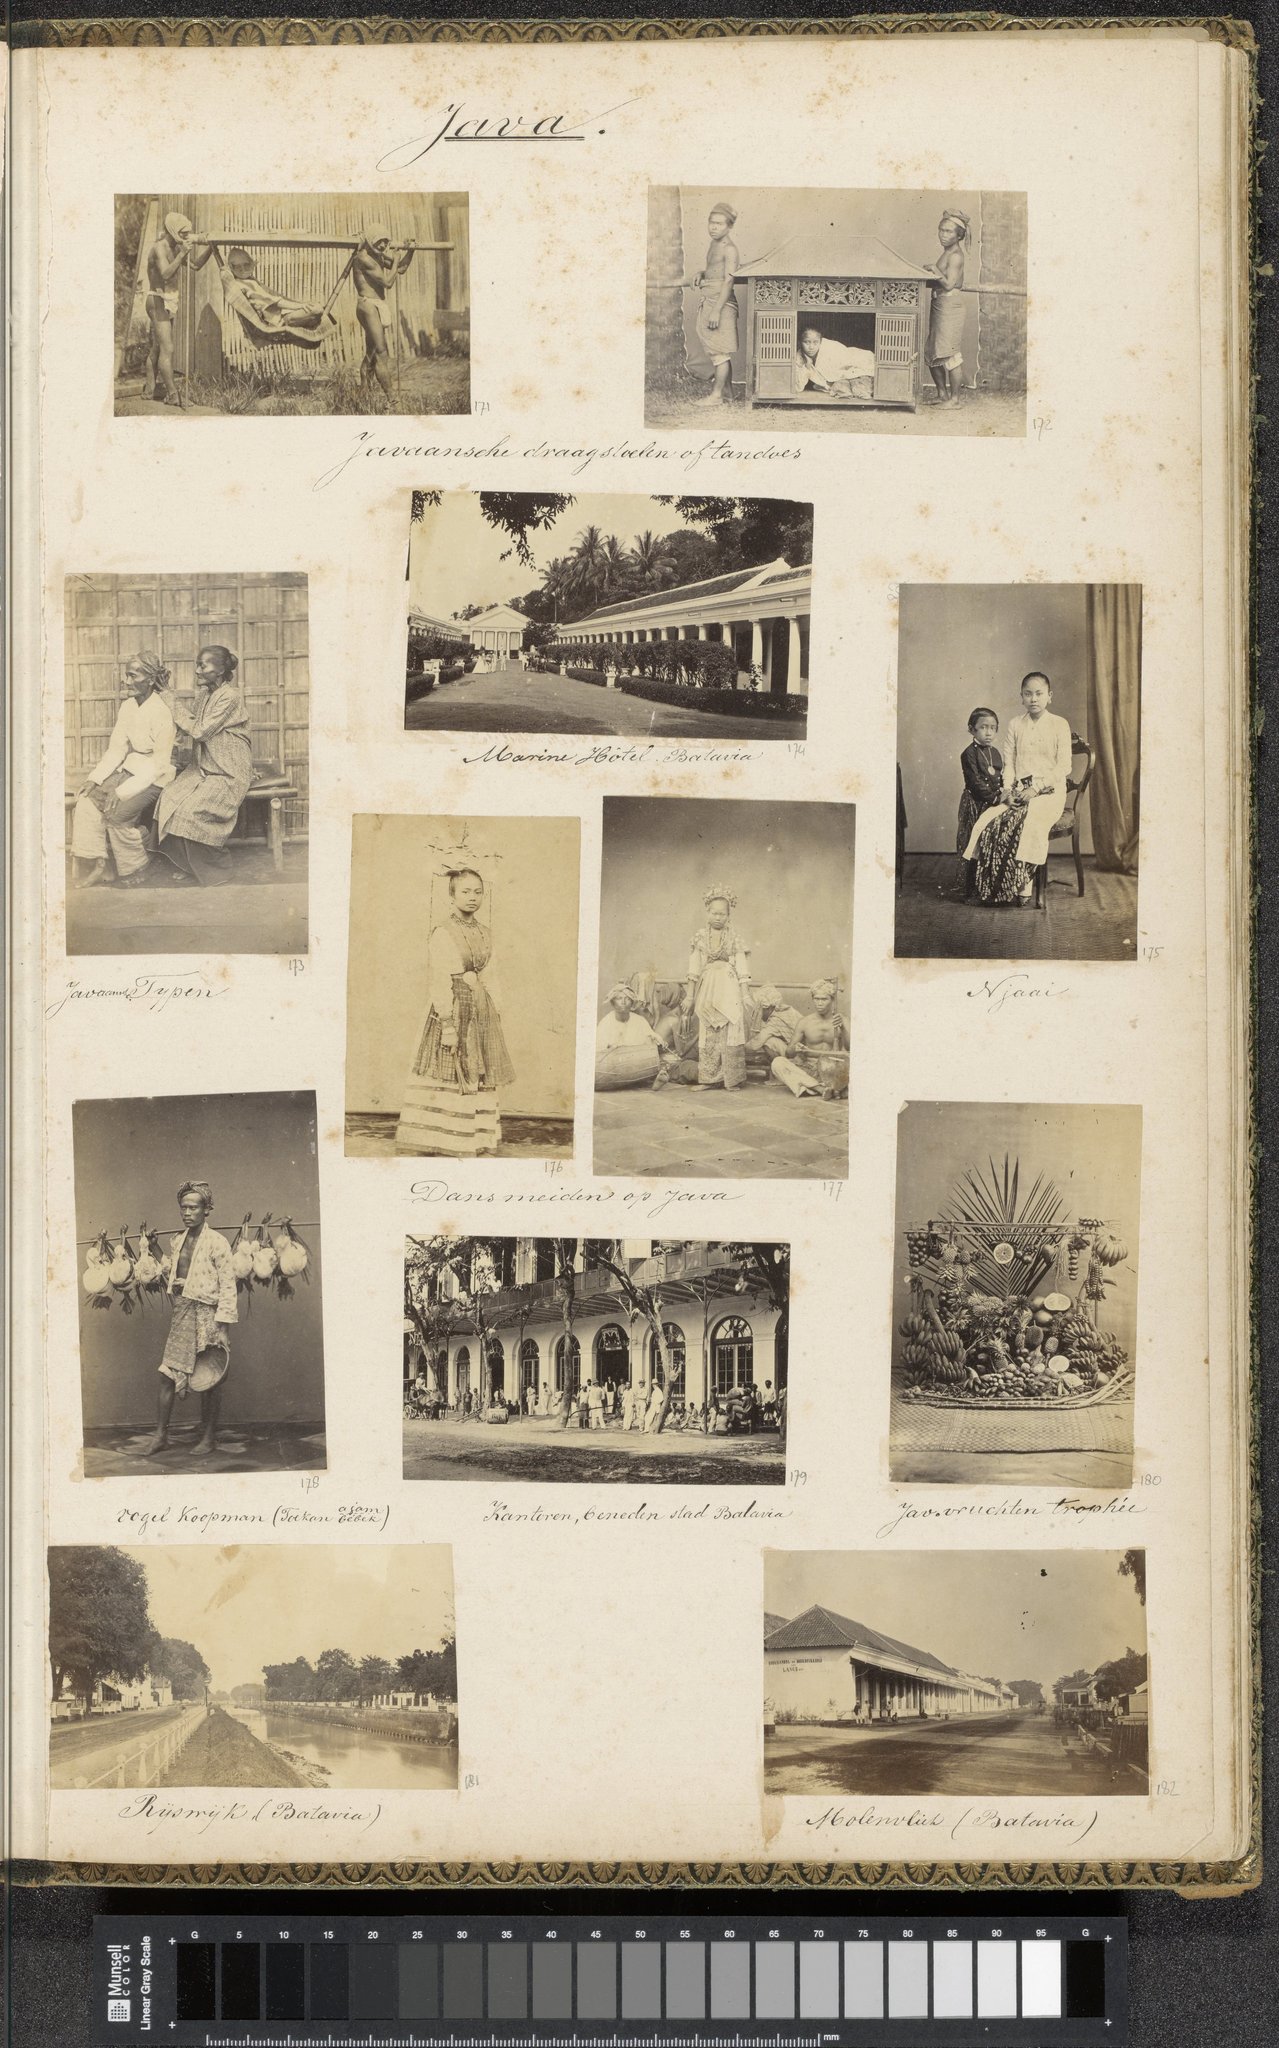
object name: photograph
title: Portret van een Javaanse vrouw (njai) met kind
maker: Anonymous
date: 1870-1880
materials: paper, photographic support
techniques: albumen print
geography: java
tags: child, house personnel, servants, java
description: Onderdeel van Fotoalbum van Robert Daniel Crommelin (1841-1907).